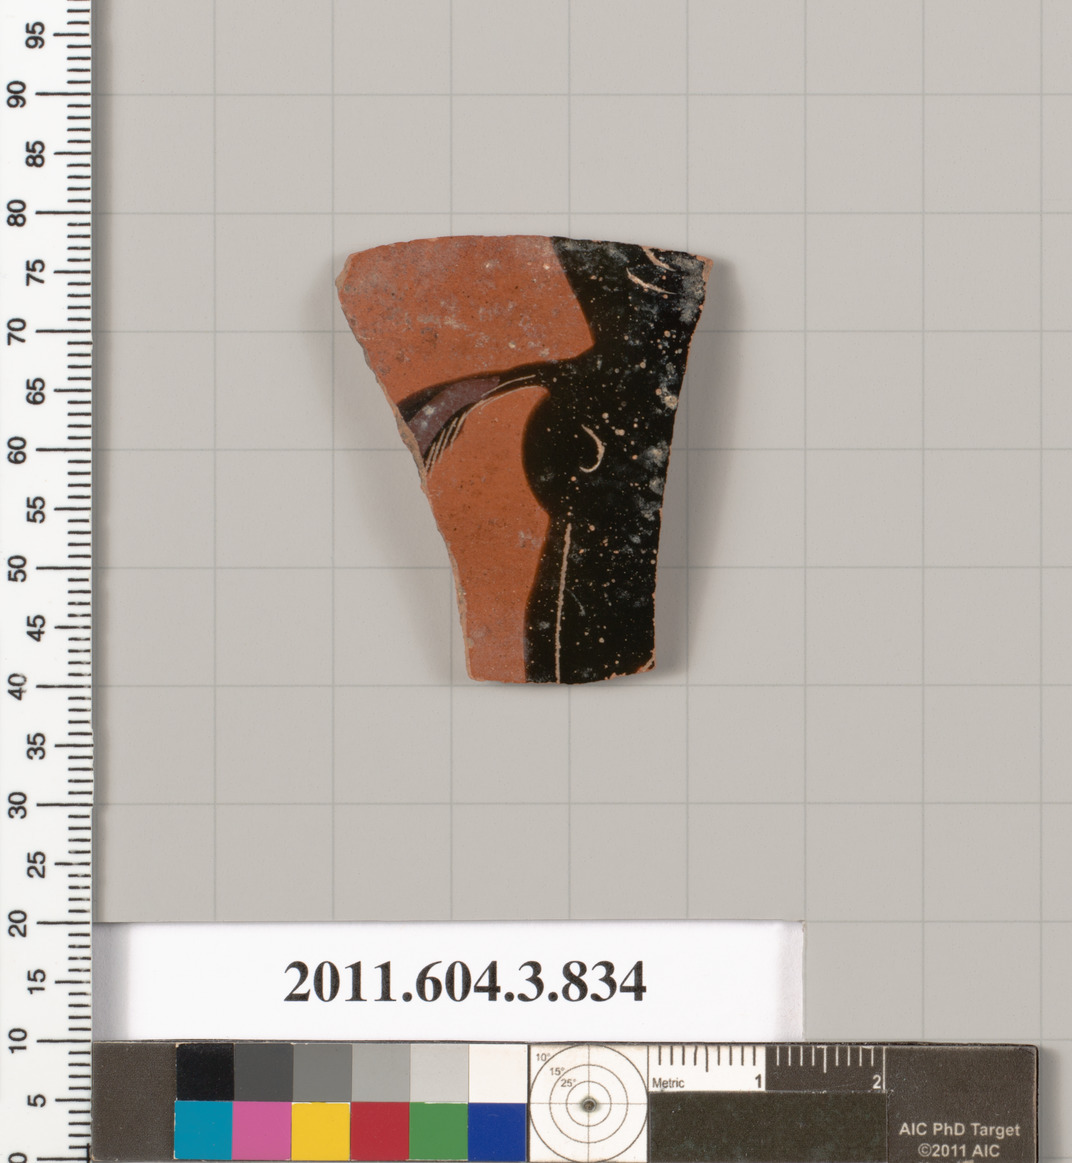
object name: lekythos fragment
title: Terracotta fragment of a lekythos (oil flask)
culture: greek, attic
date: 534-468 BCE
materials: terracotta